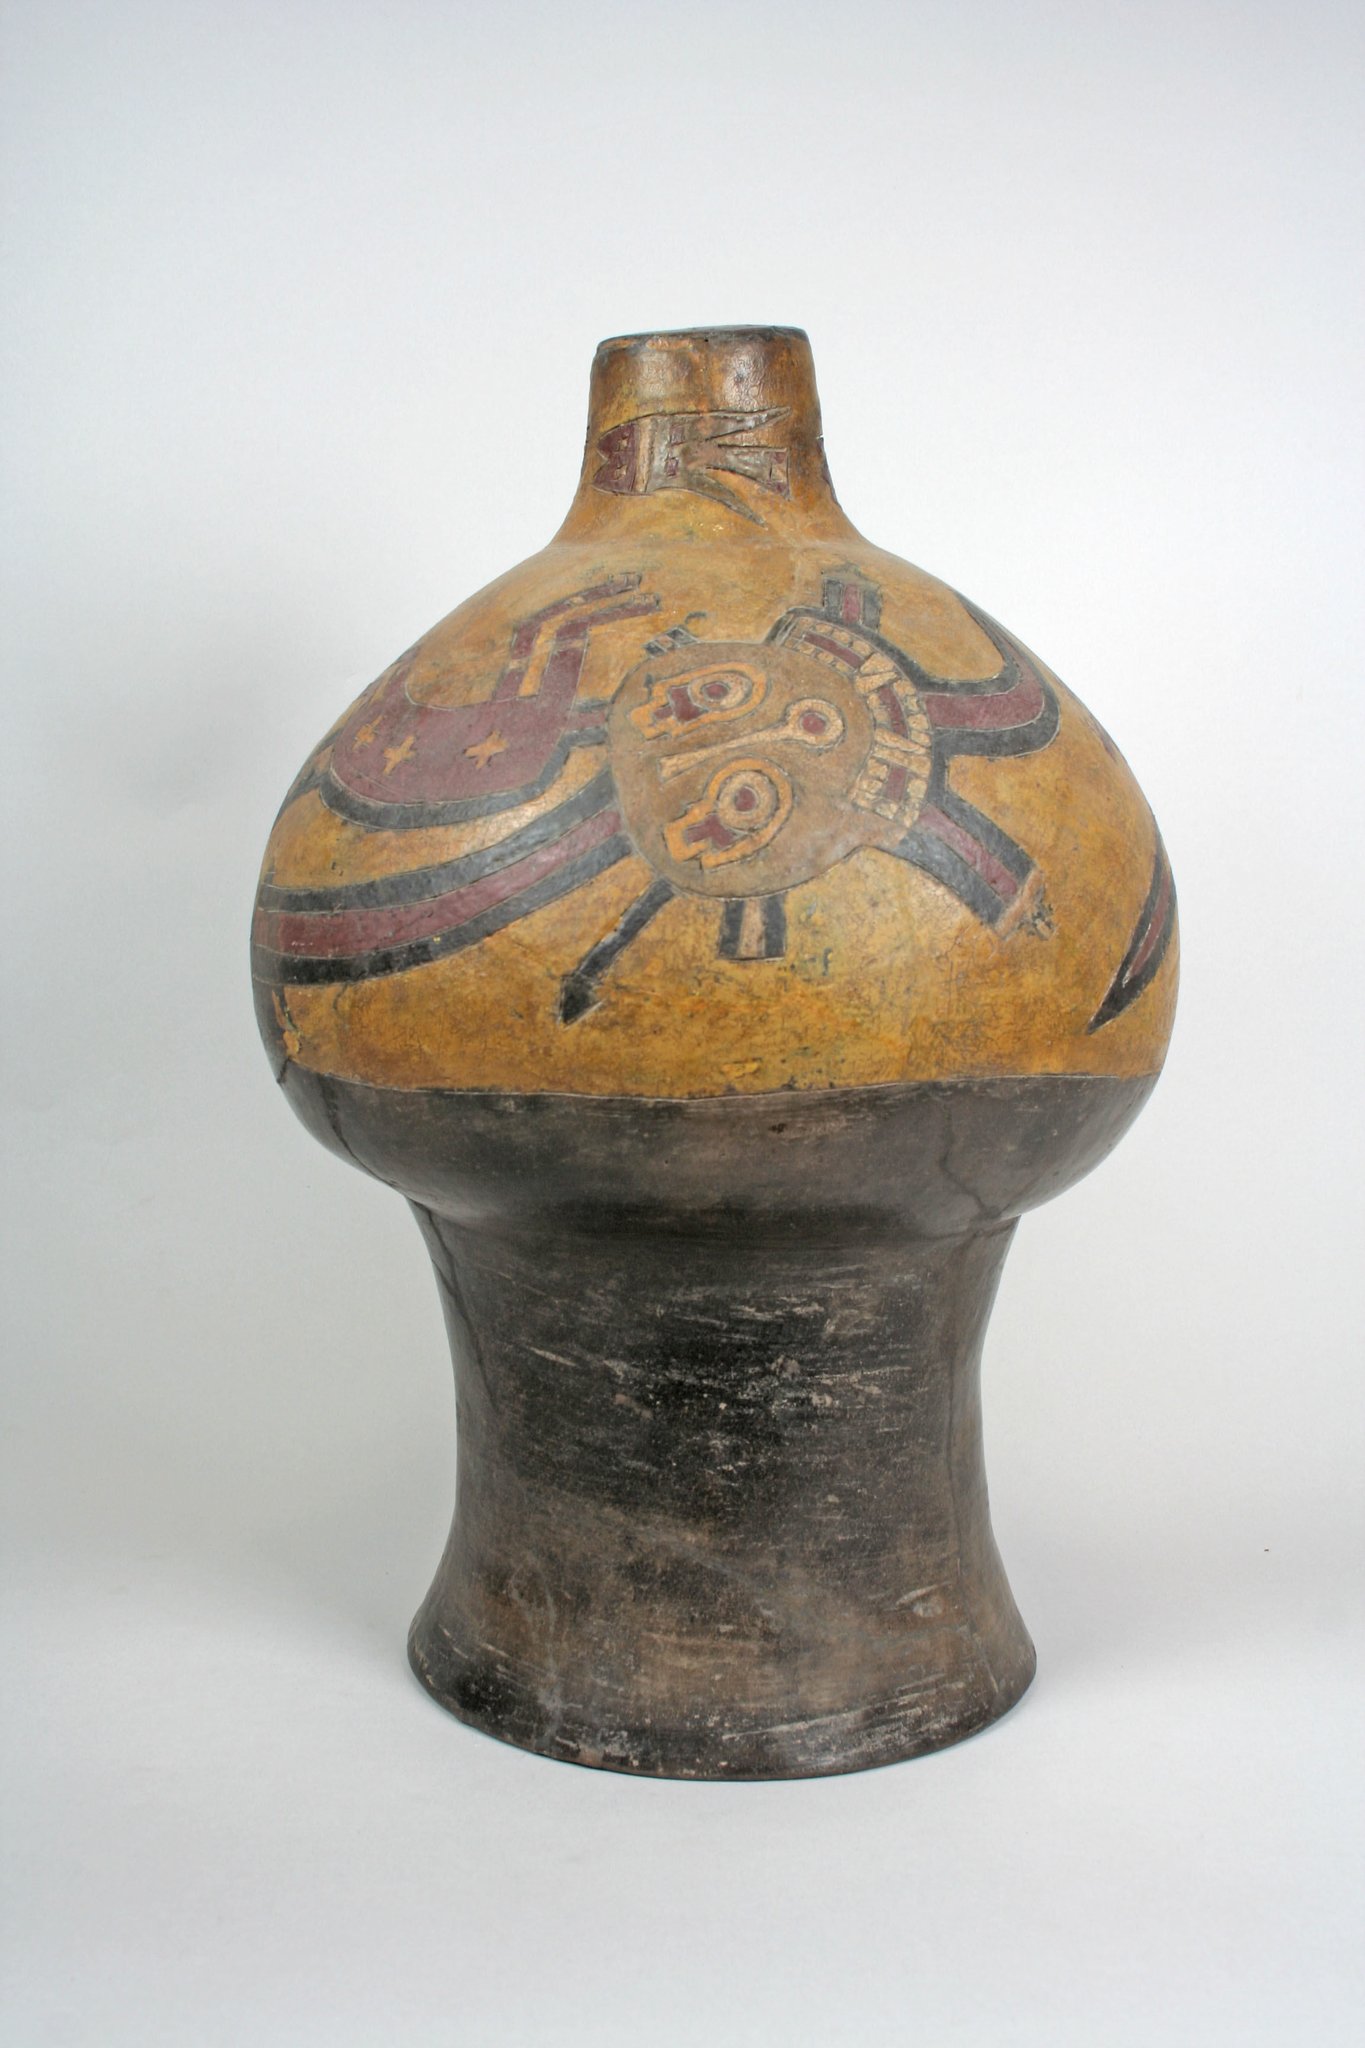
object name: drum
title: Drum, Monkey Figures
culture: paracas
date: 400-101 BCE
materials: ceramic, paint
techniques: firing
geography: peru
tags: monkeys